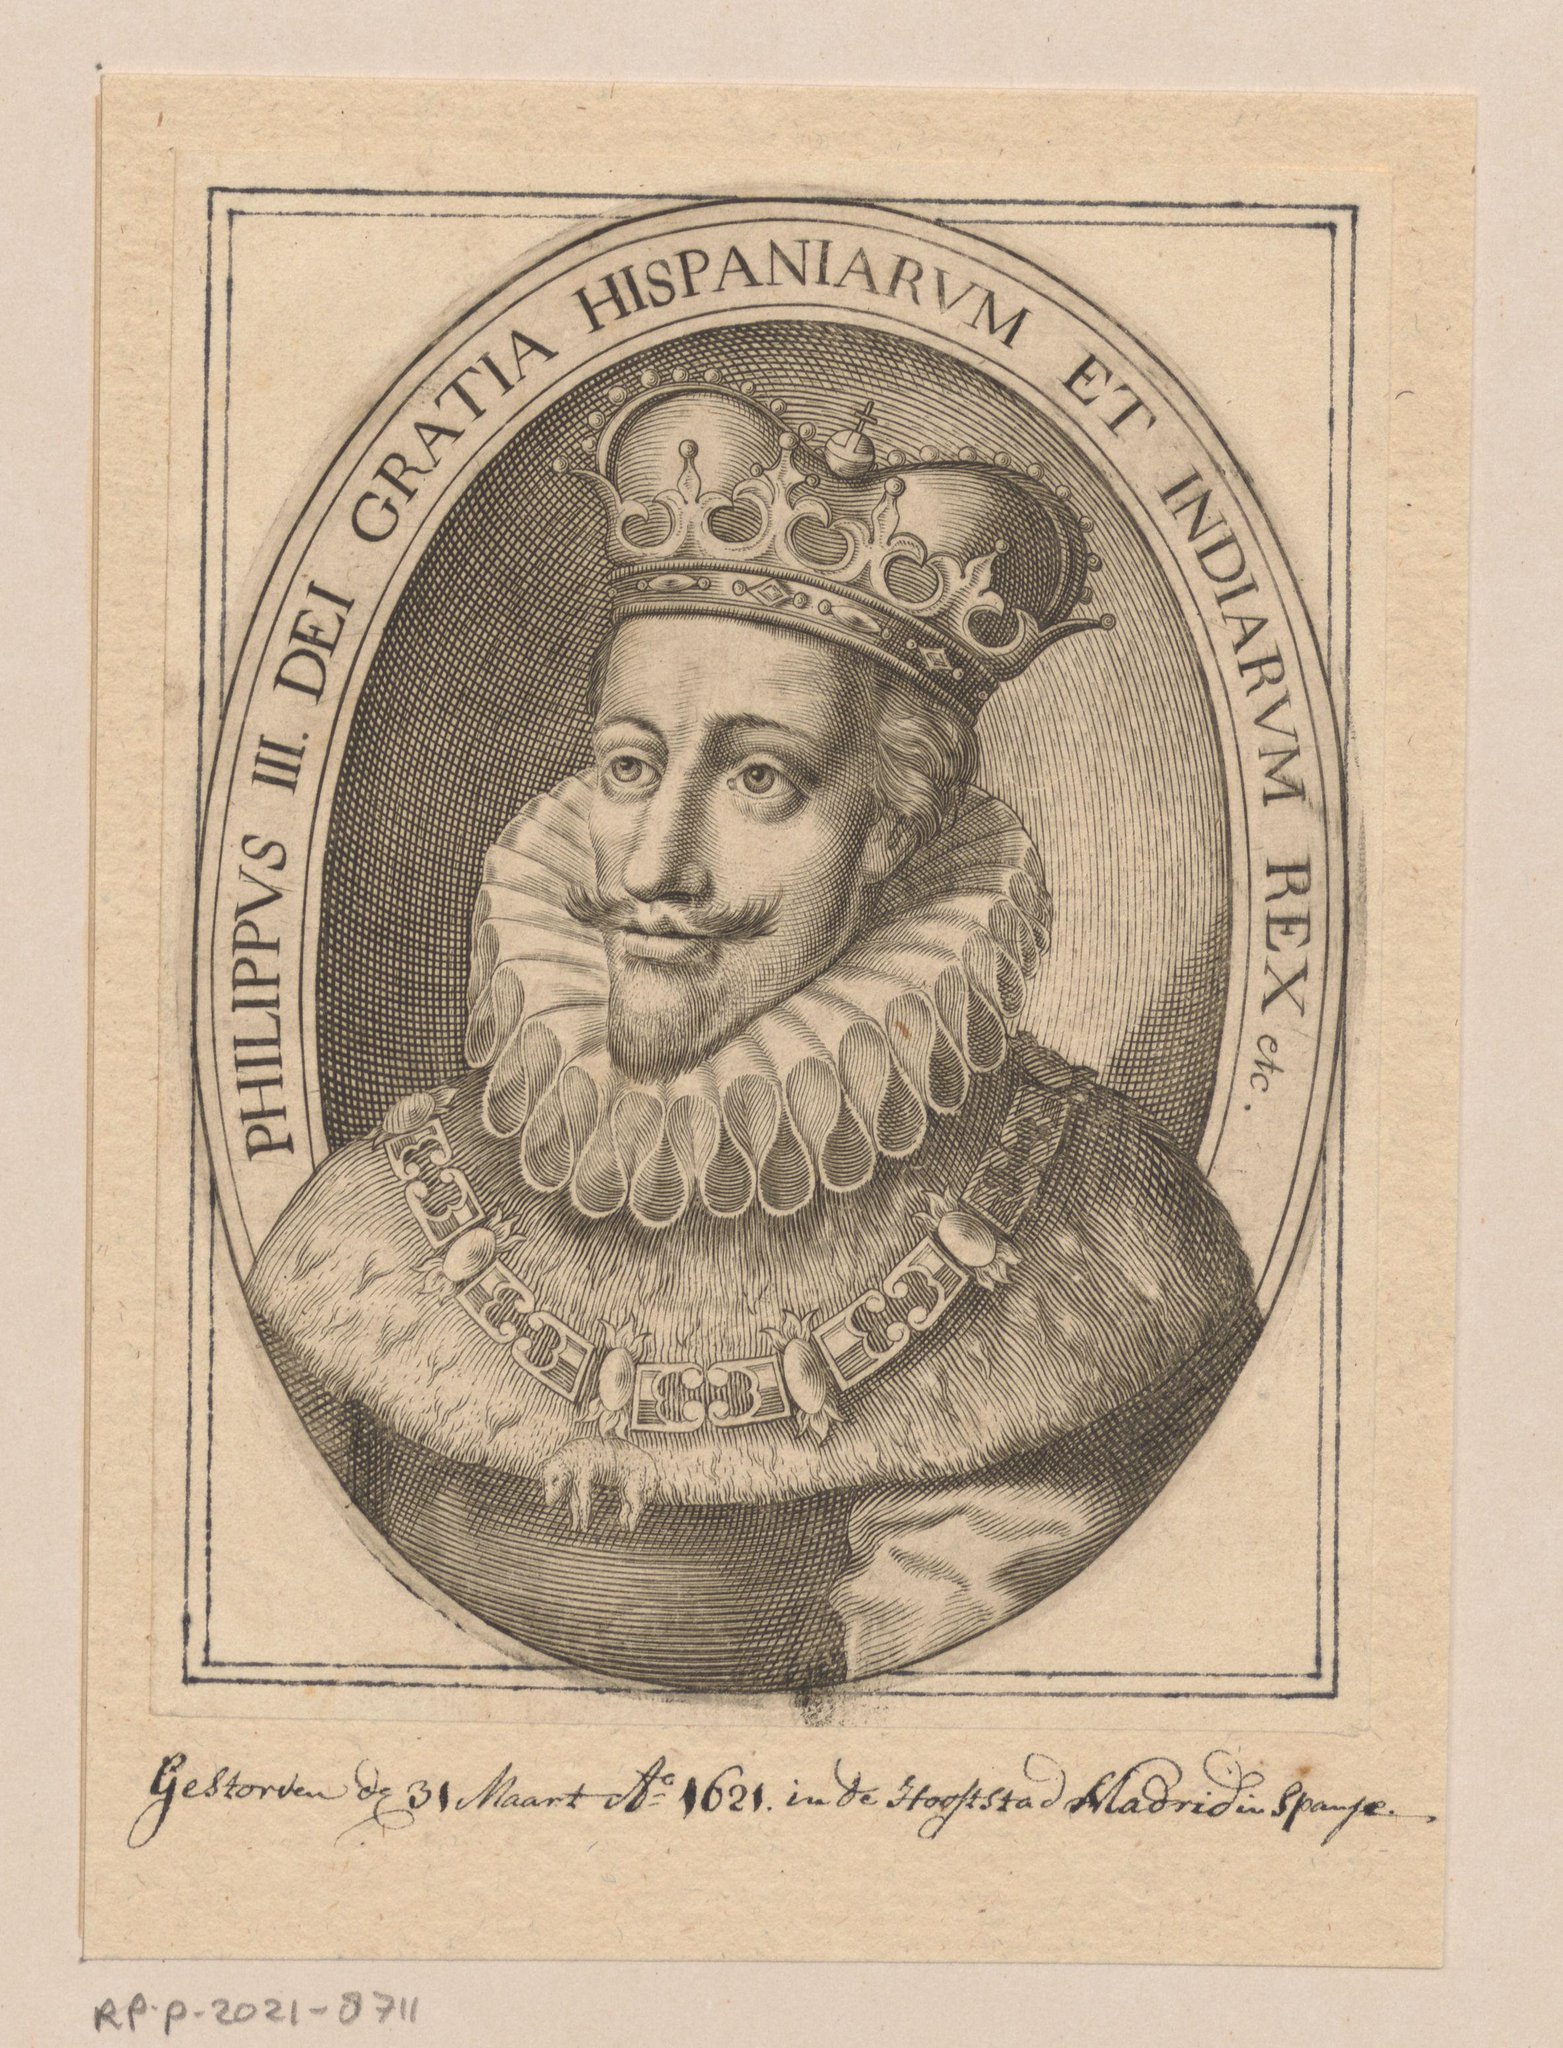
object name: print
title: Portret van Filips III, koning van Spanje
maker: Anonymous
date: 1626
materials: paper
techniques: engraving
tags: filips iii (koning van spanje), historical persons, knighthood order of the golden fleece, insignia and symbols of sovereignty (crown, diadem, sceptre, orb, seal, standard, cloak, pectoral)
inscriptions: inscription: ‘Gestorven de 31 Maart A 1621 in de Hooftstad Madrid in Spanje’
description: Prent mogelijk uit: Gysius, Johannes. Oorspronck ende voortgang der Neder-landscher beroerten (...). Delft: Jan Andriesz. Cloeting, 1626.